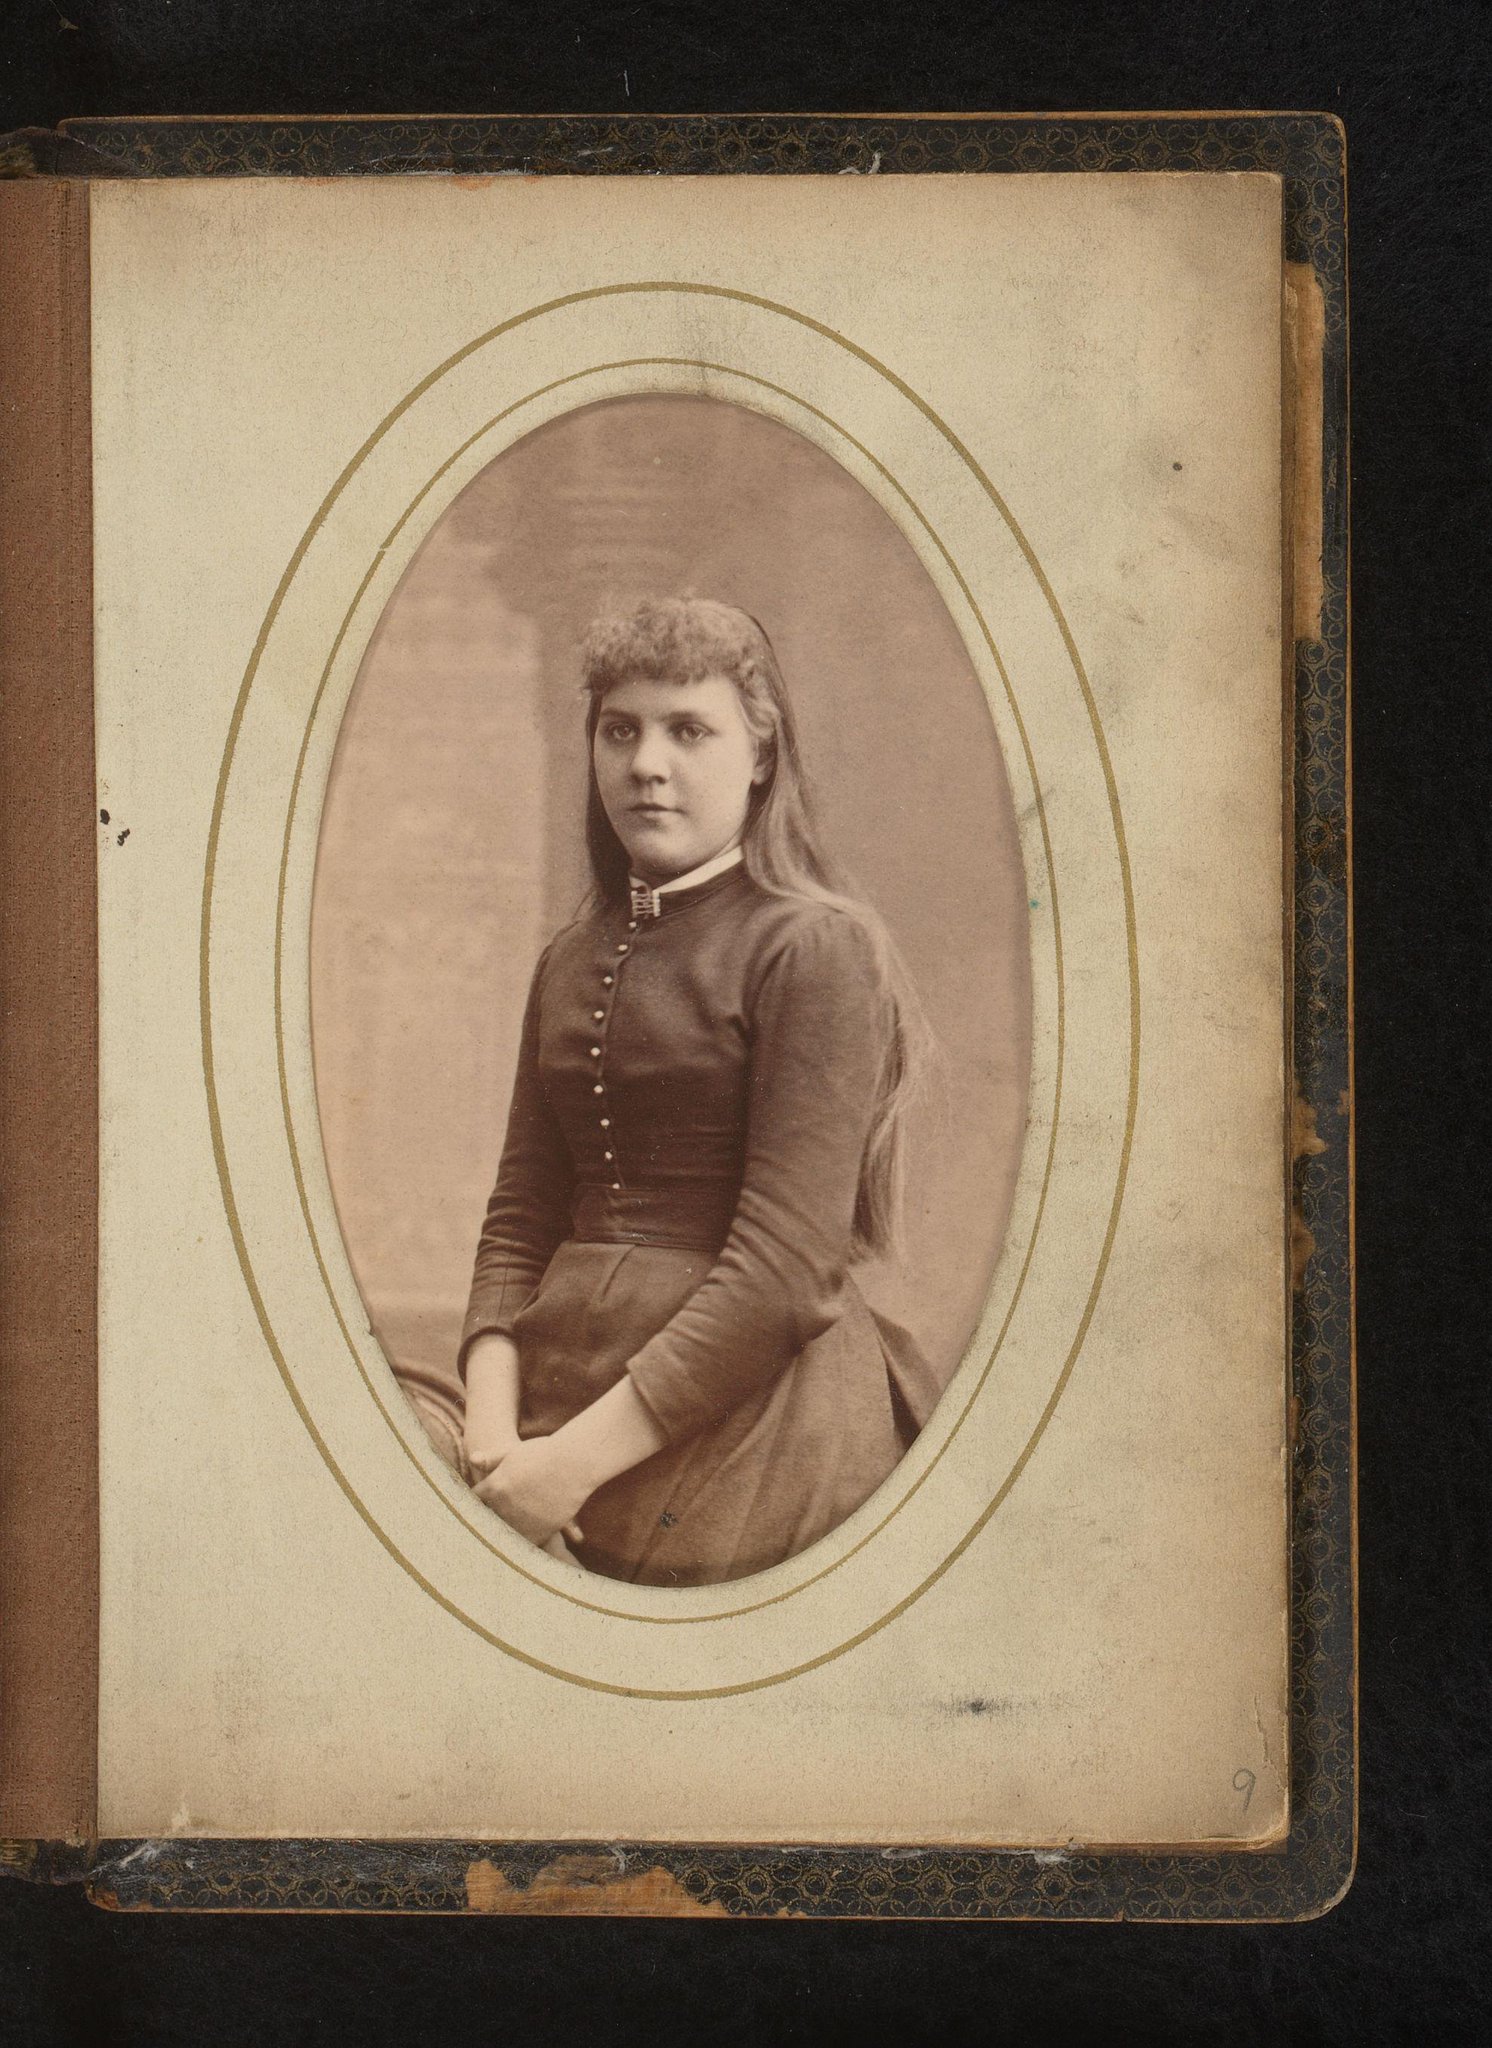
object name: photograph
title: Portret van een jonge vrouw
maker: vandyke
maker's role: fotograaf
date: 1860-1900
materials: cardboard, photographic support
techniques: albumen print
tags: adolescent, young woman, maiden, historical persons